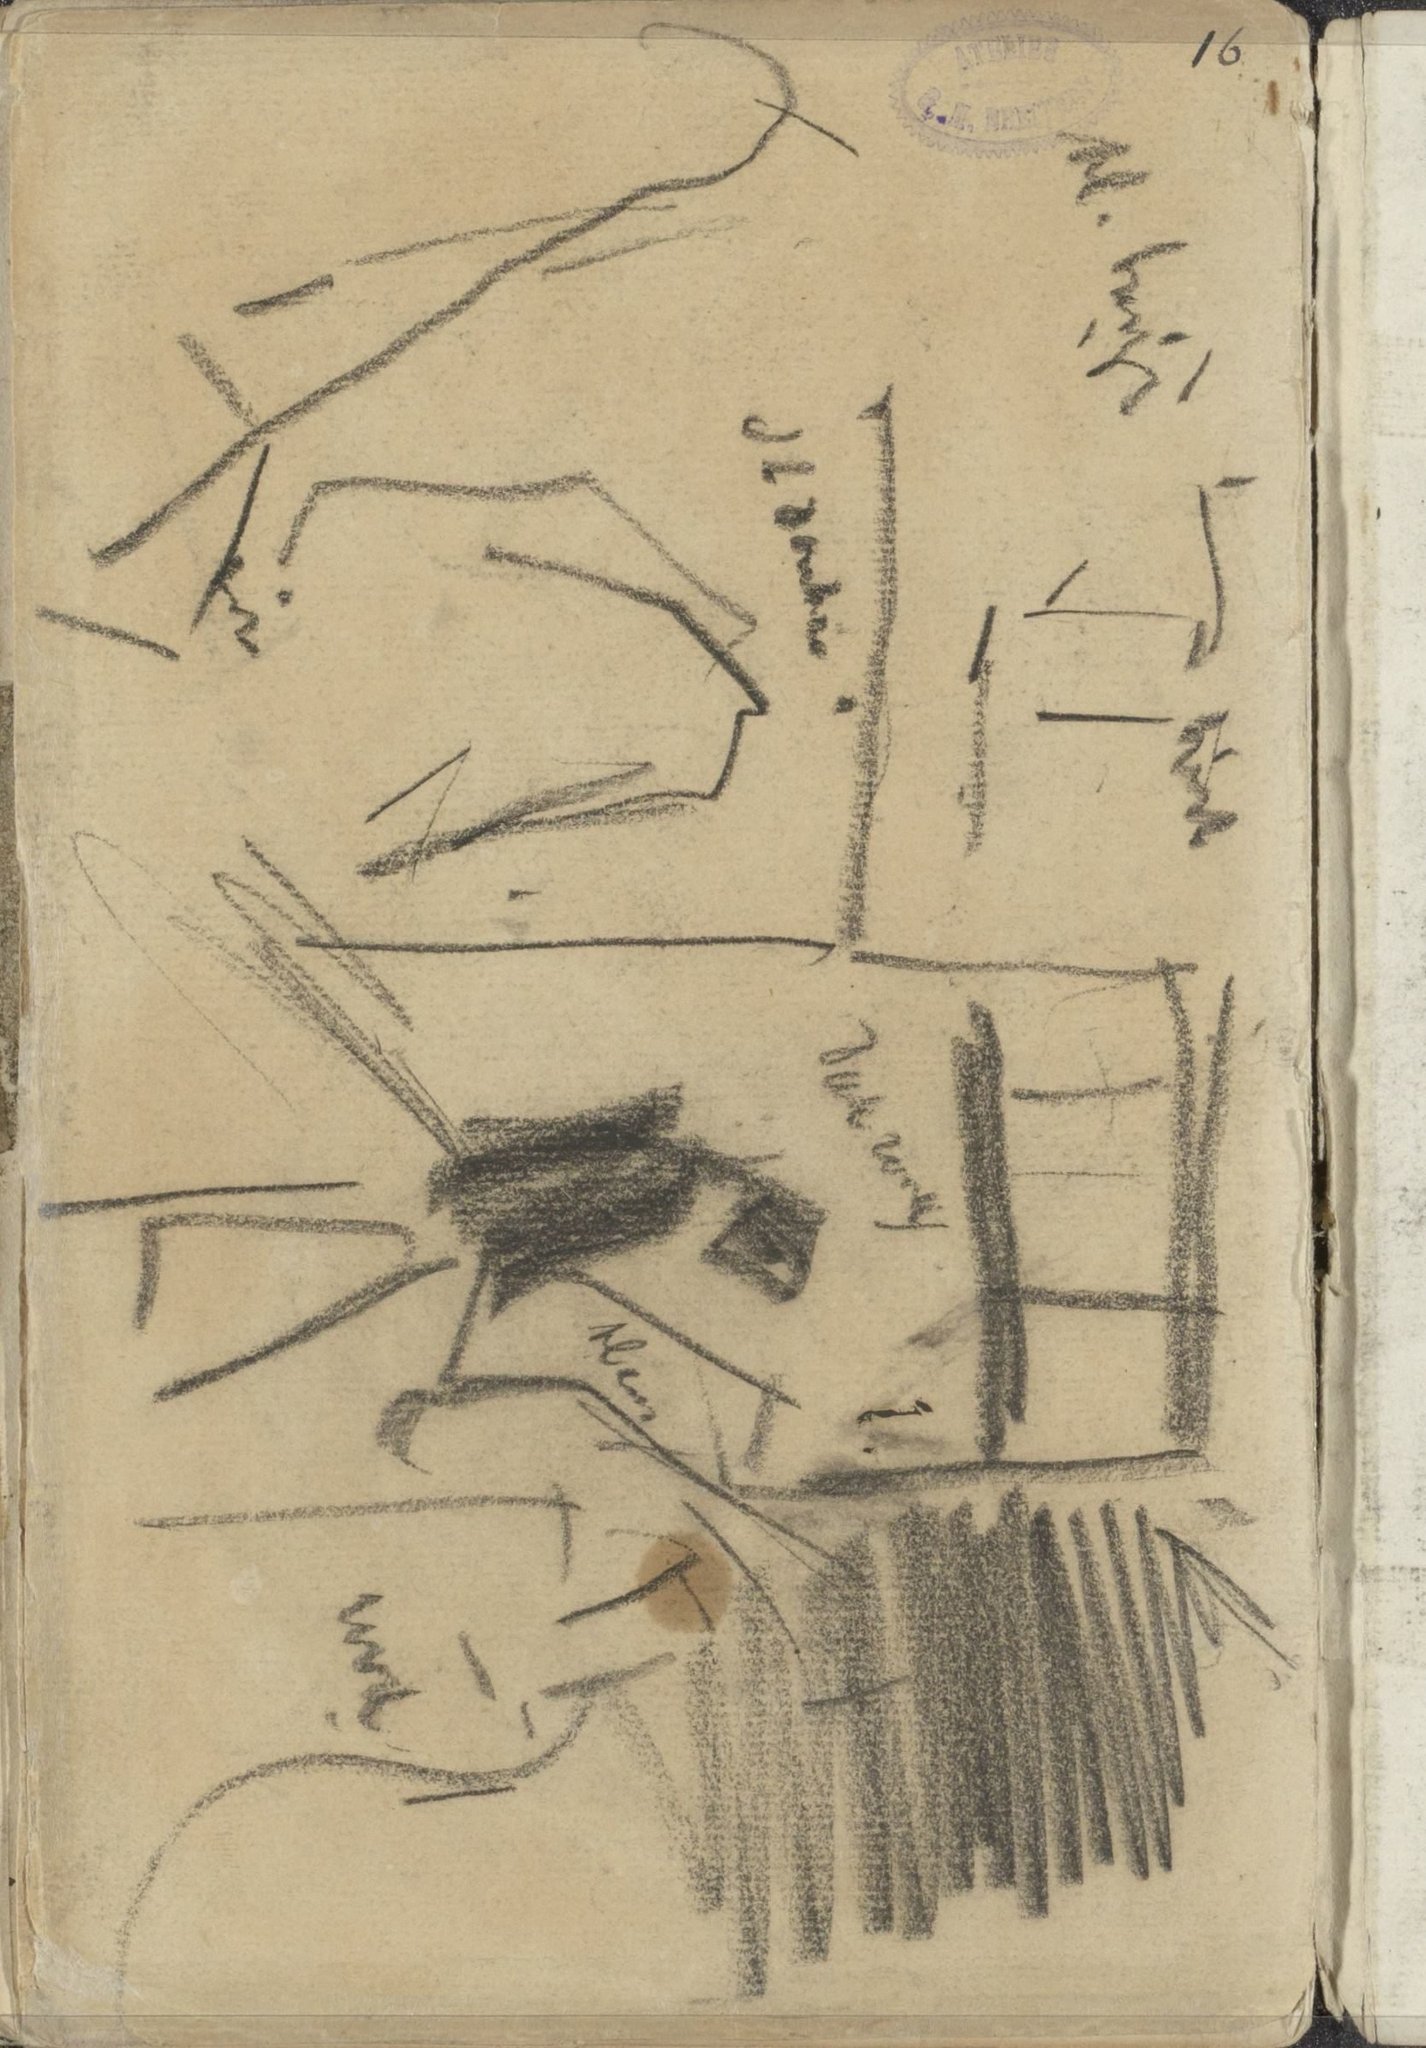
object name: sketchbook leaf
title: Figuren voor een gebouw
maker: george hendrik breitner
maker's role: draughtsman, painter, print maker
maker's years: 1857-1923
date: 1904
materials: chalk, paper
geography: amsterdam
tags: civic architecture; edifices; dwellings, city-view, and landscape with man-made constructions (+ city(-scape) with figures, staffage)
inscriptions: workshop stamp: Lugt 291d, :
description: Pagina 29 uit een schetsboek met 14 bladen.